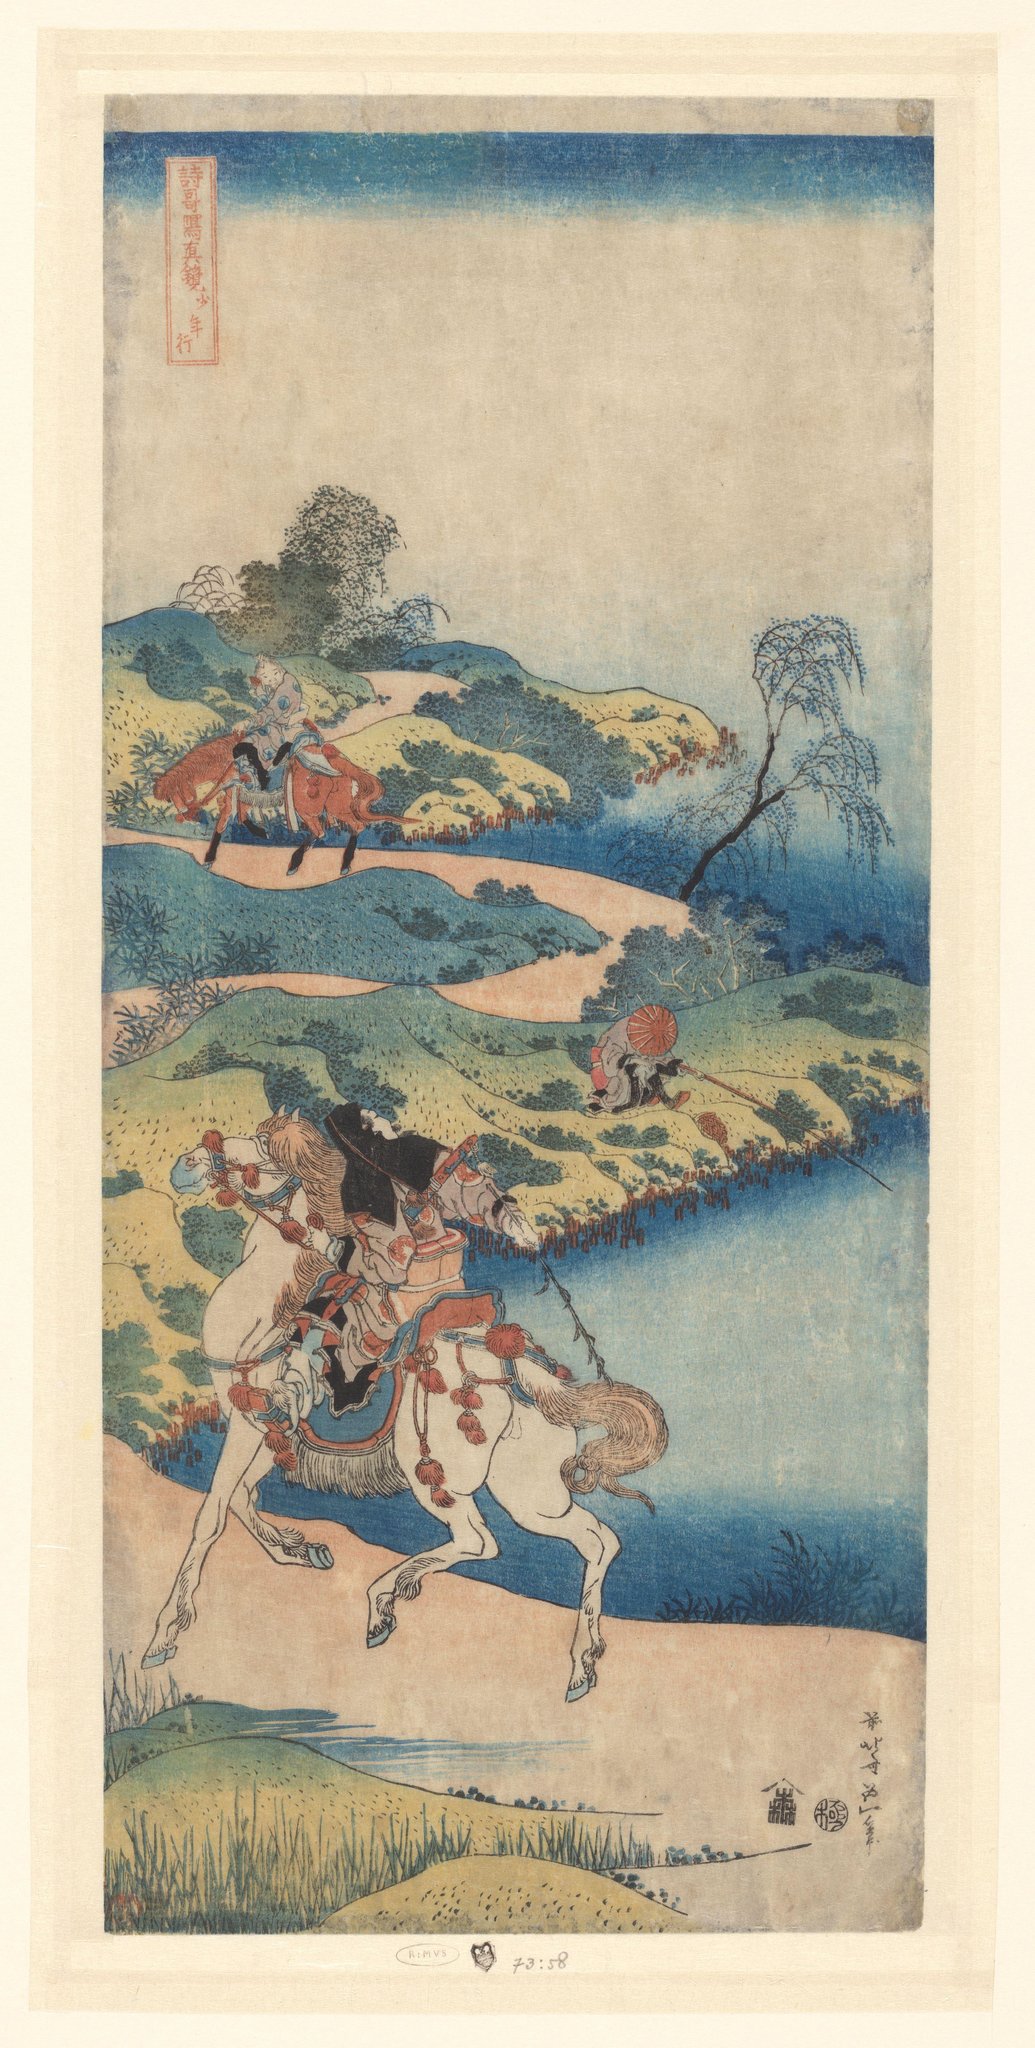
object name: print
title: Spiegel van beroemde Japanse en Chinese gedichten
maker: katsushika hokusai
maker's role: draughtsman, print maker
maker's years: 1760-1849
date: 1832-1836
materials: paper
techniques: woodcut, nishiki e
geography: tokyo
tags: riding a horse, ass, or mule; rider, horseman, water course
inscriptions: collector's mark: Lugt 2228, collector's mark: Lugt 2760